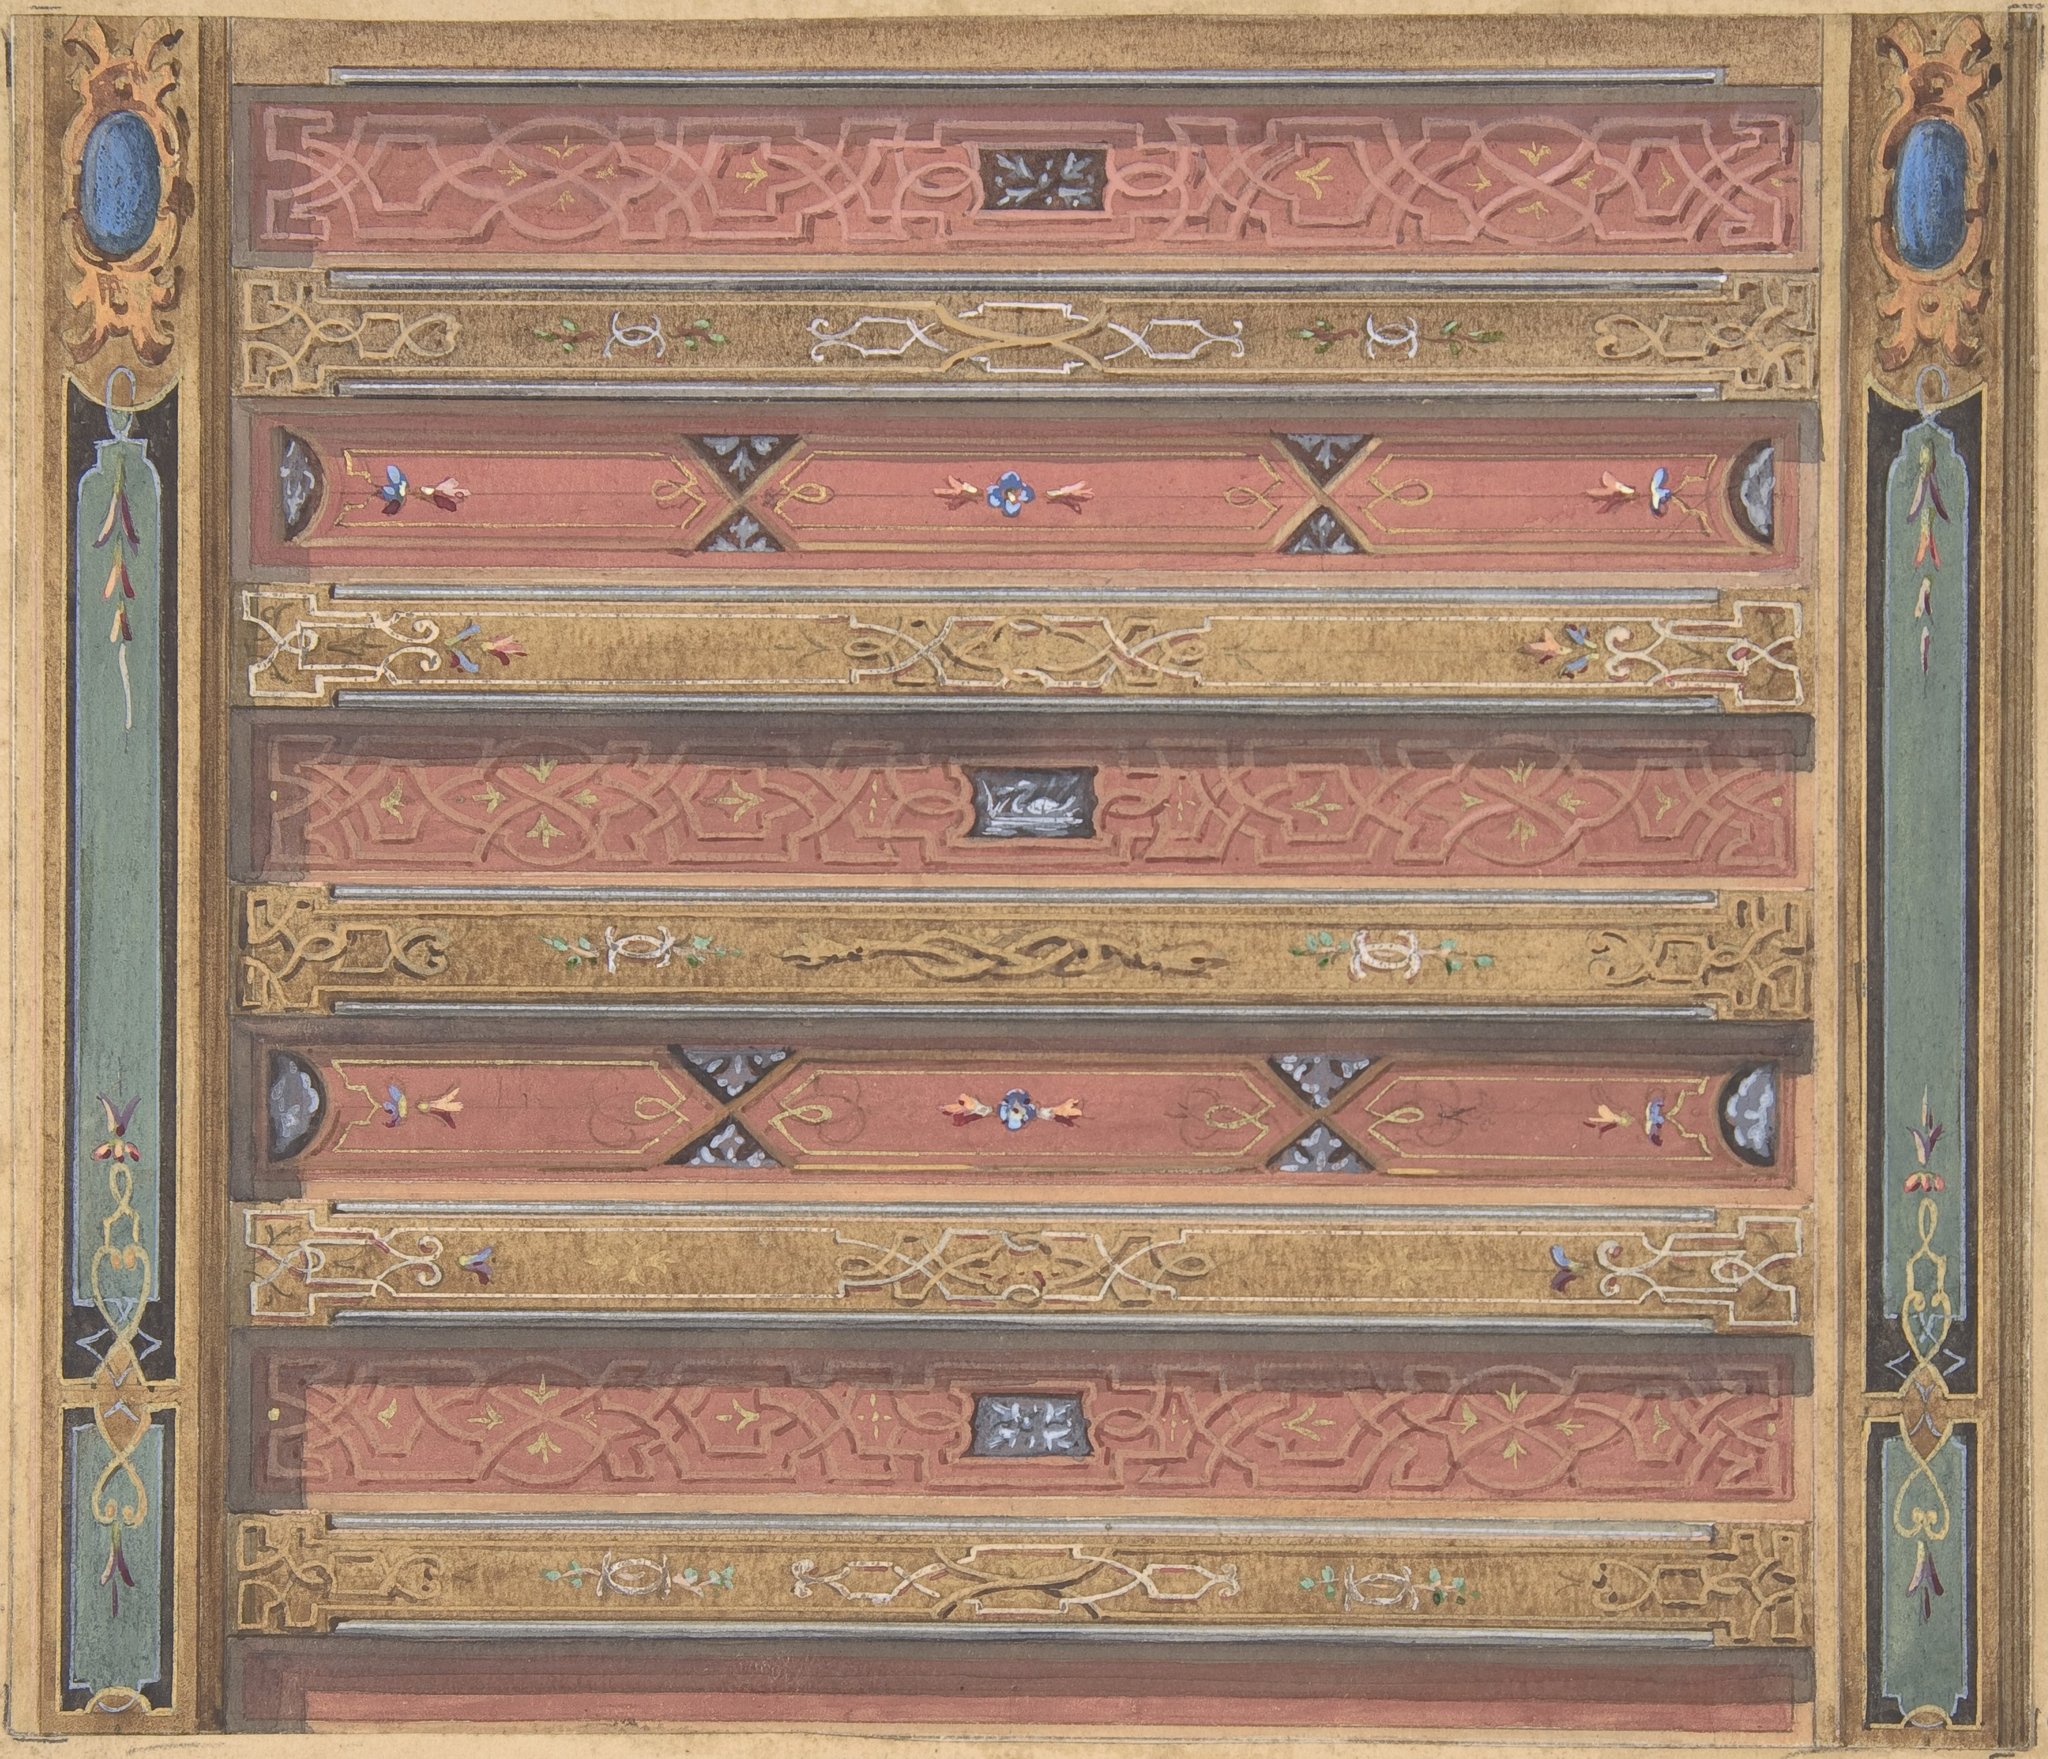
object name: drawing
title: Design for Salon Ceiling, Château de Cangé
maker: jules-edmond-charles lachaise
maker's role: artist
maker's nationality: french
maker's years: 1897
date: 1851-1900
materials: gouache, ink, watercolor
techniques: pen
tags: ceilings